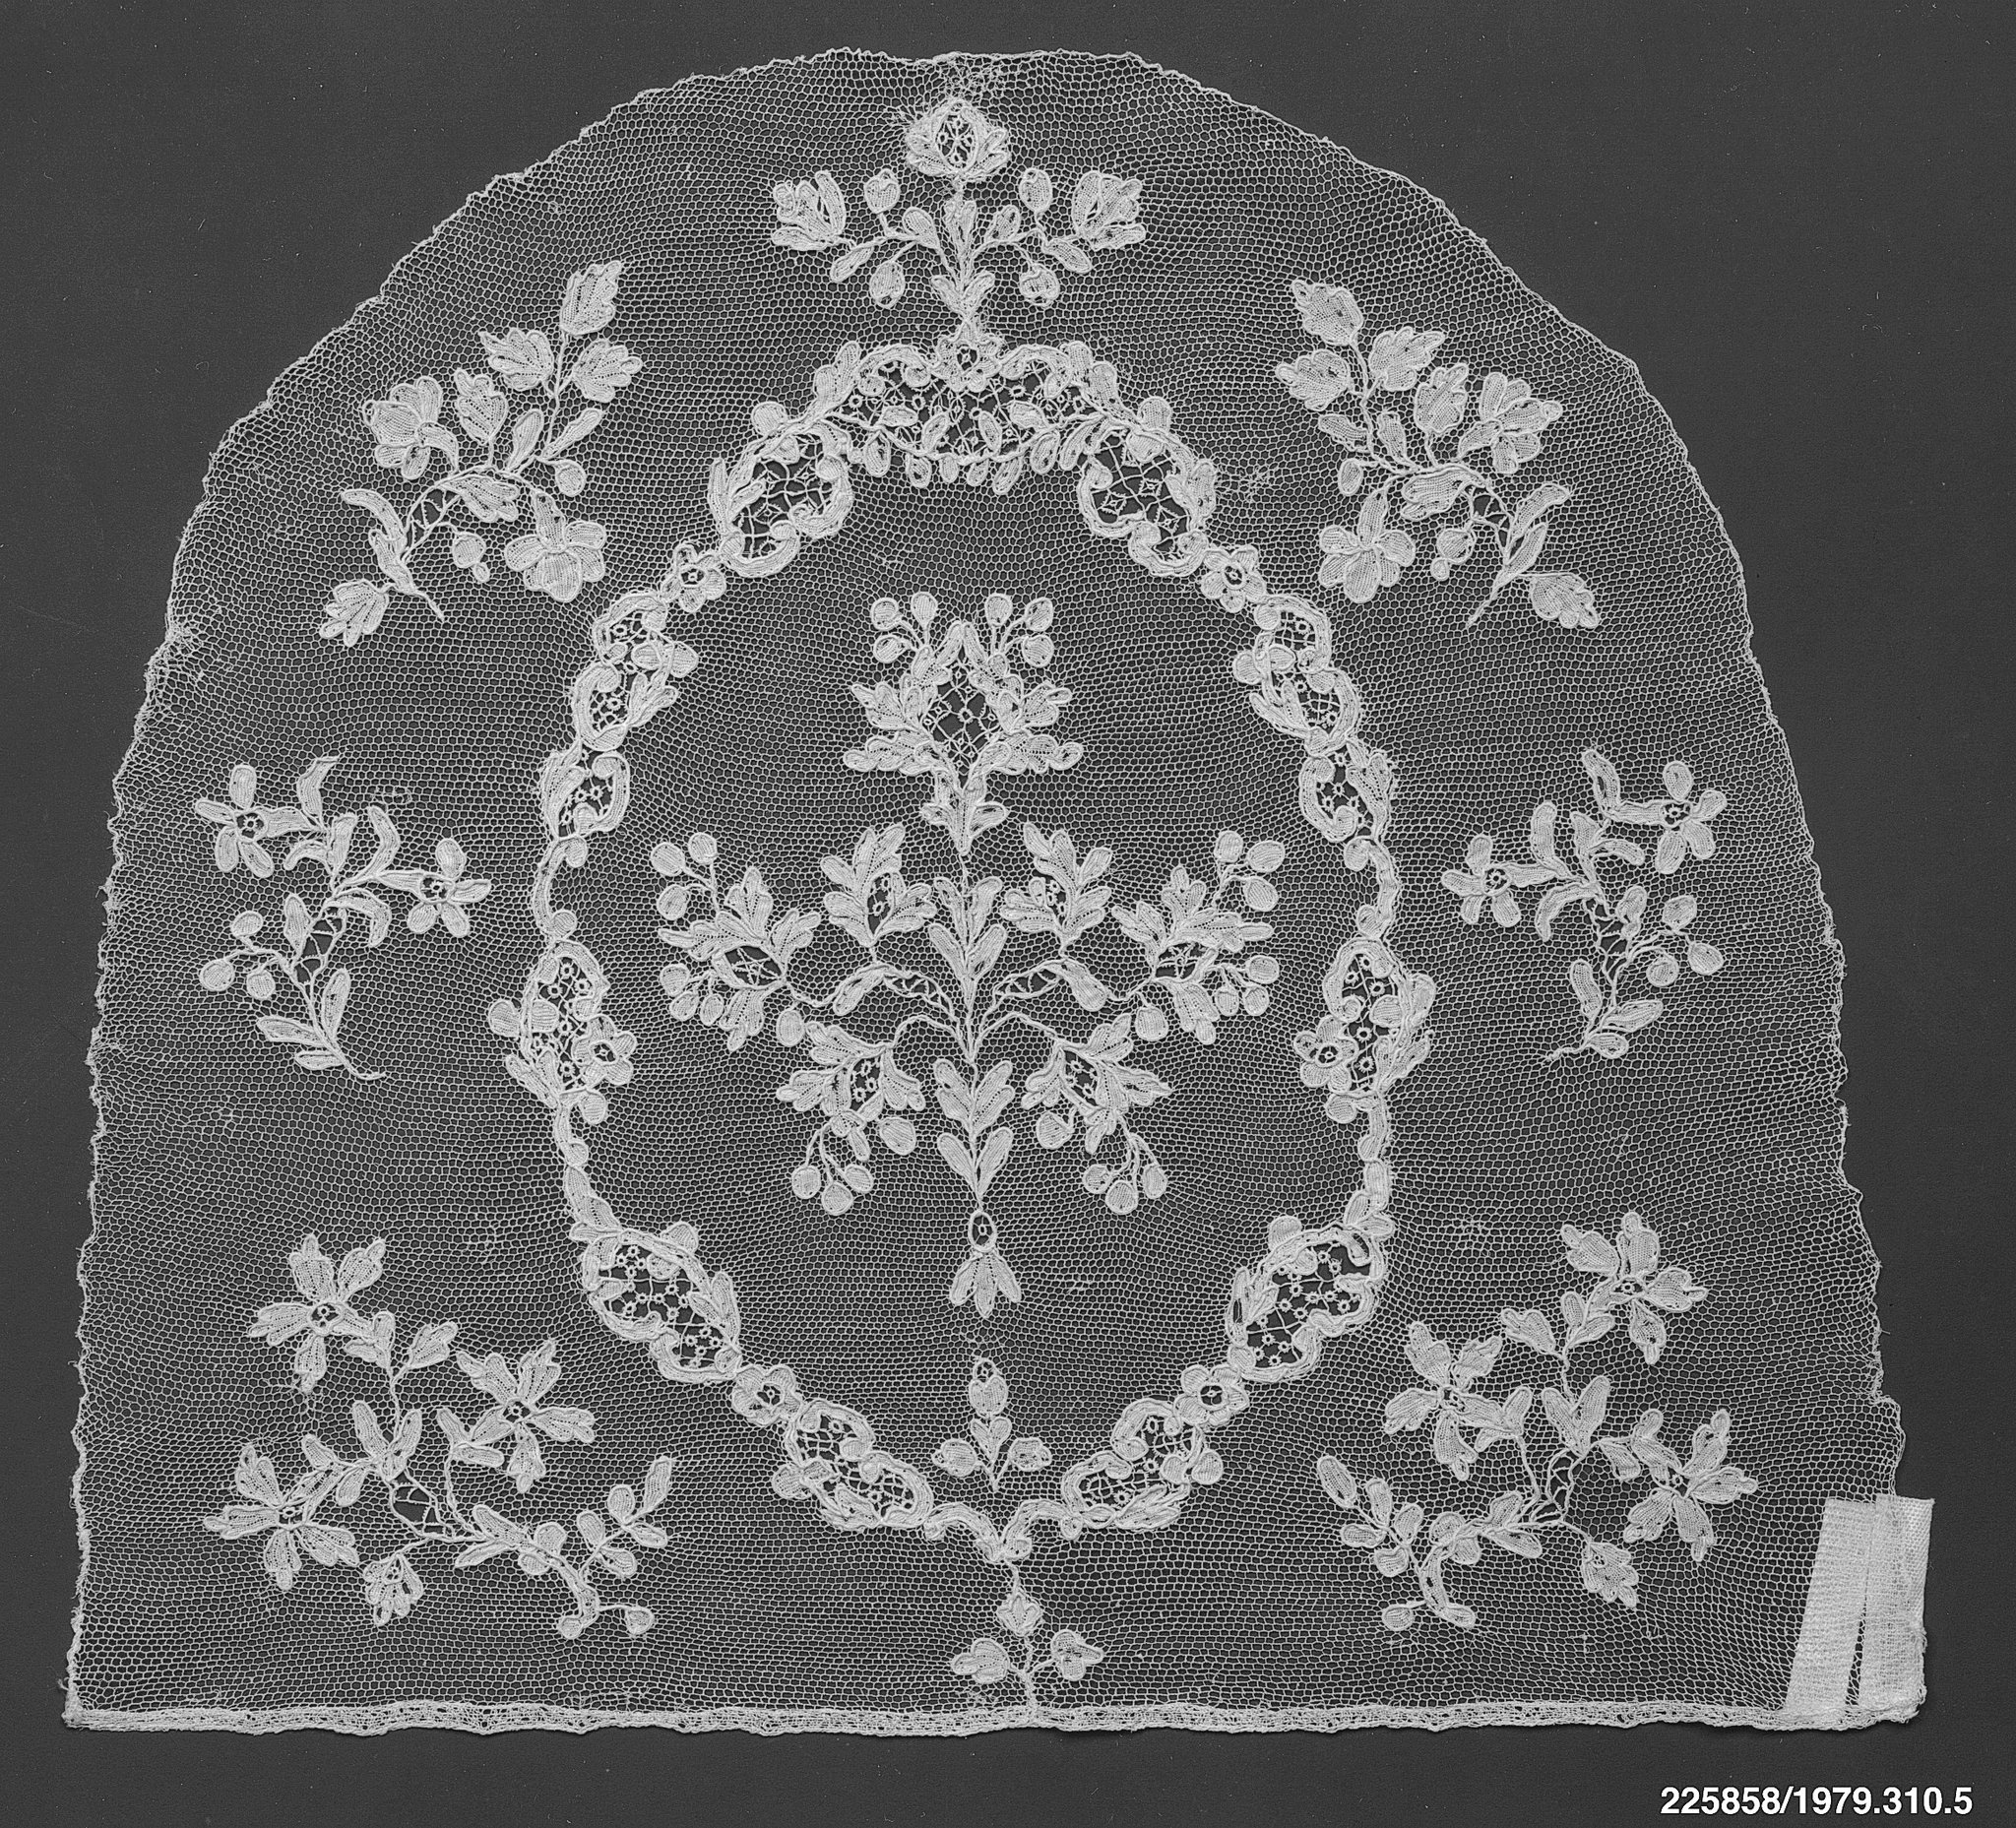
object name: cap crown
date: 1767-1800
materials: linen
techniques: lace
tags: flowers